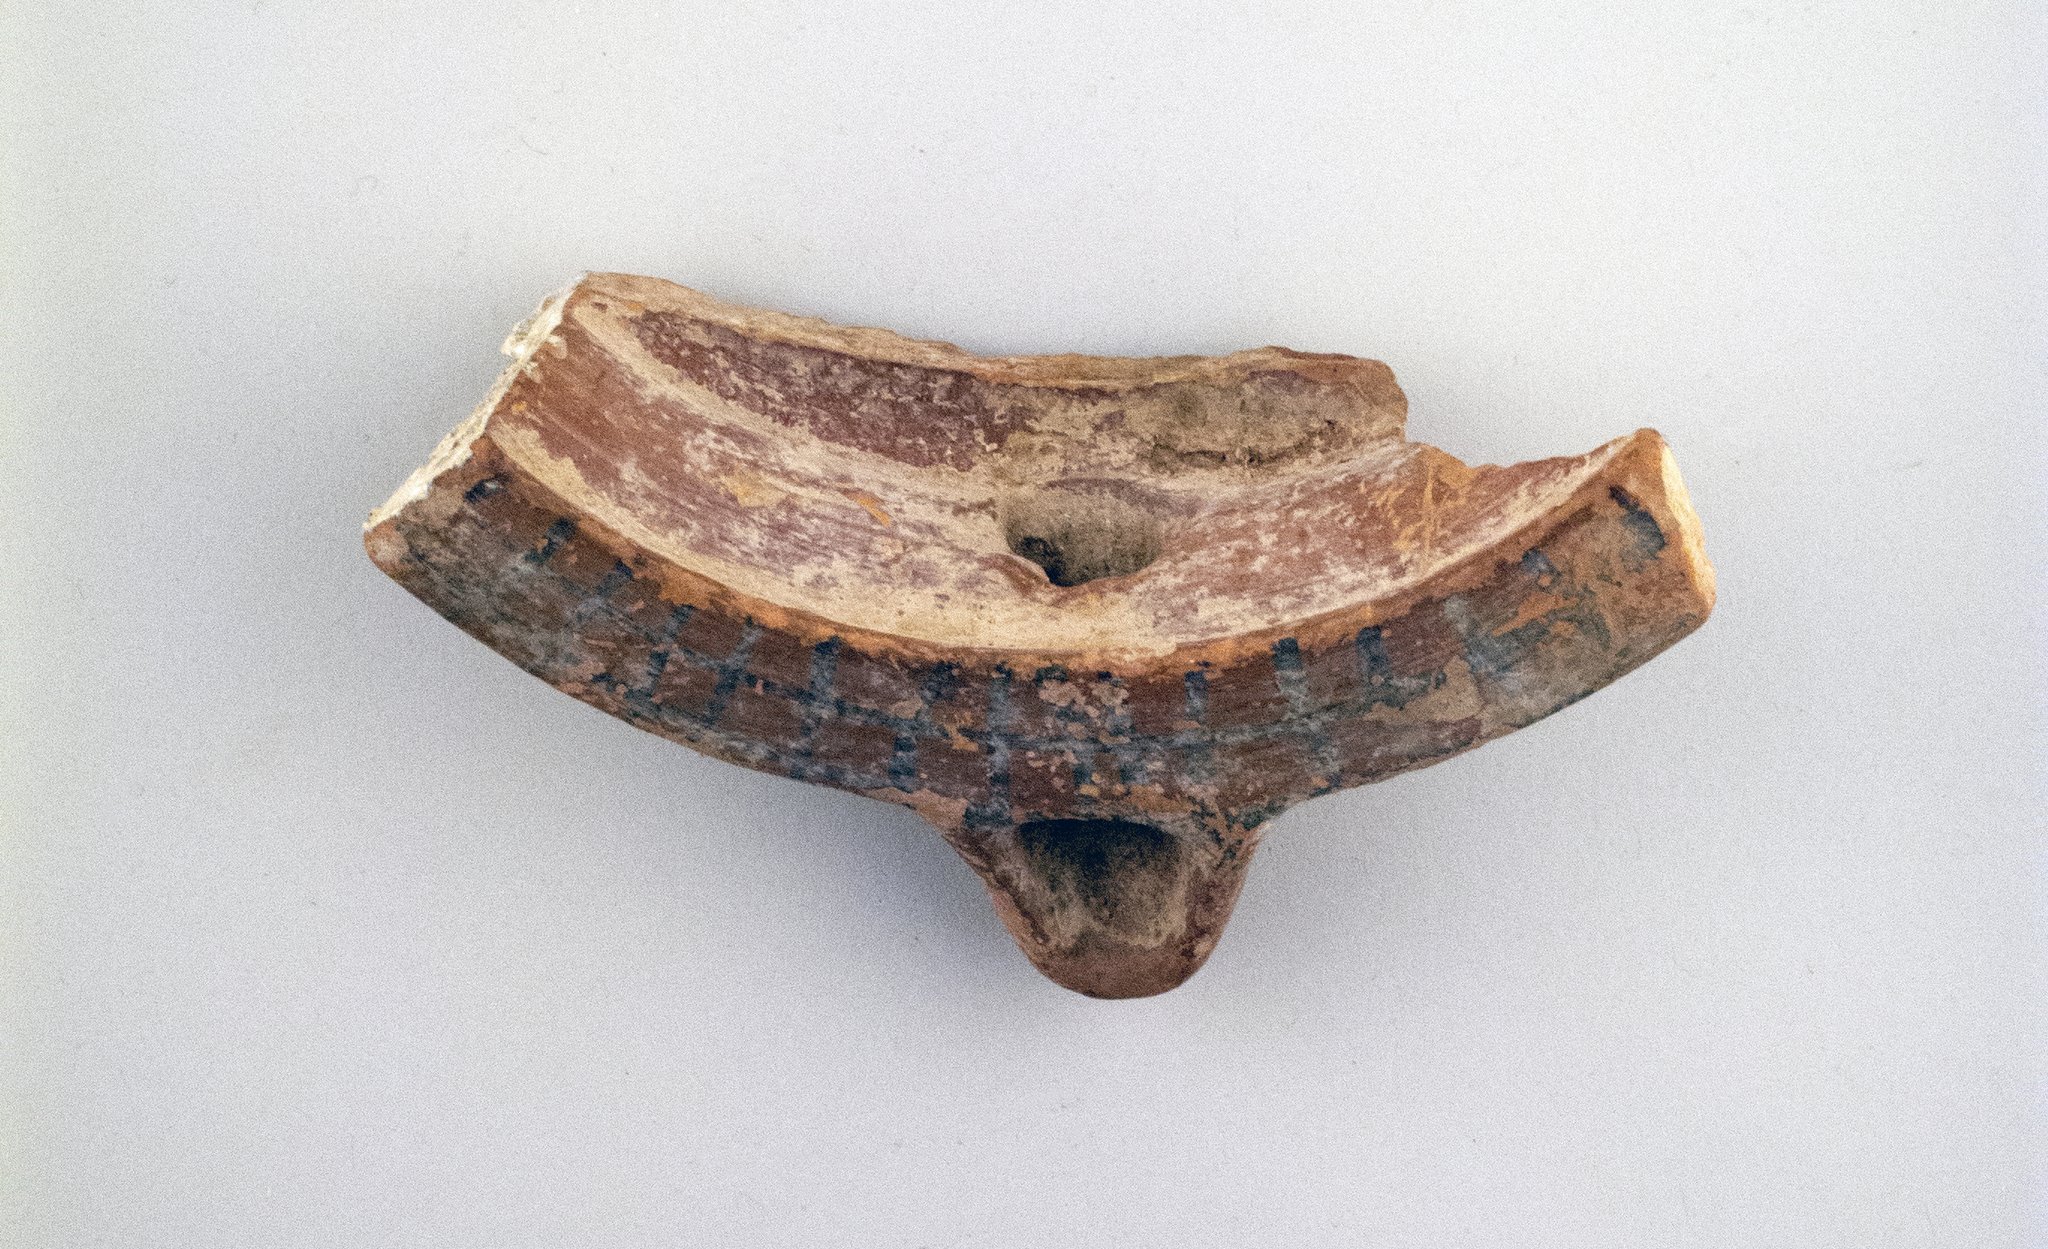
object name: lamp nozzle and rim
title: Terracotta lamp nozzle and rim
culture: greek or lydian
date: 900-30 BCE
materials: terracotta